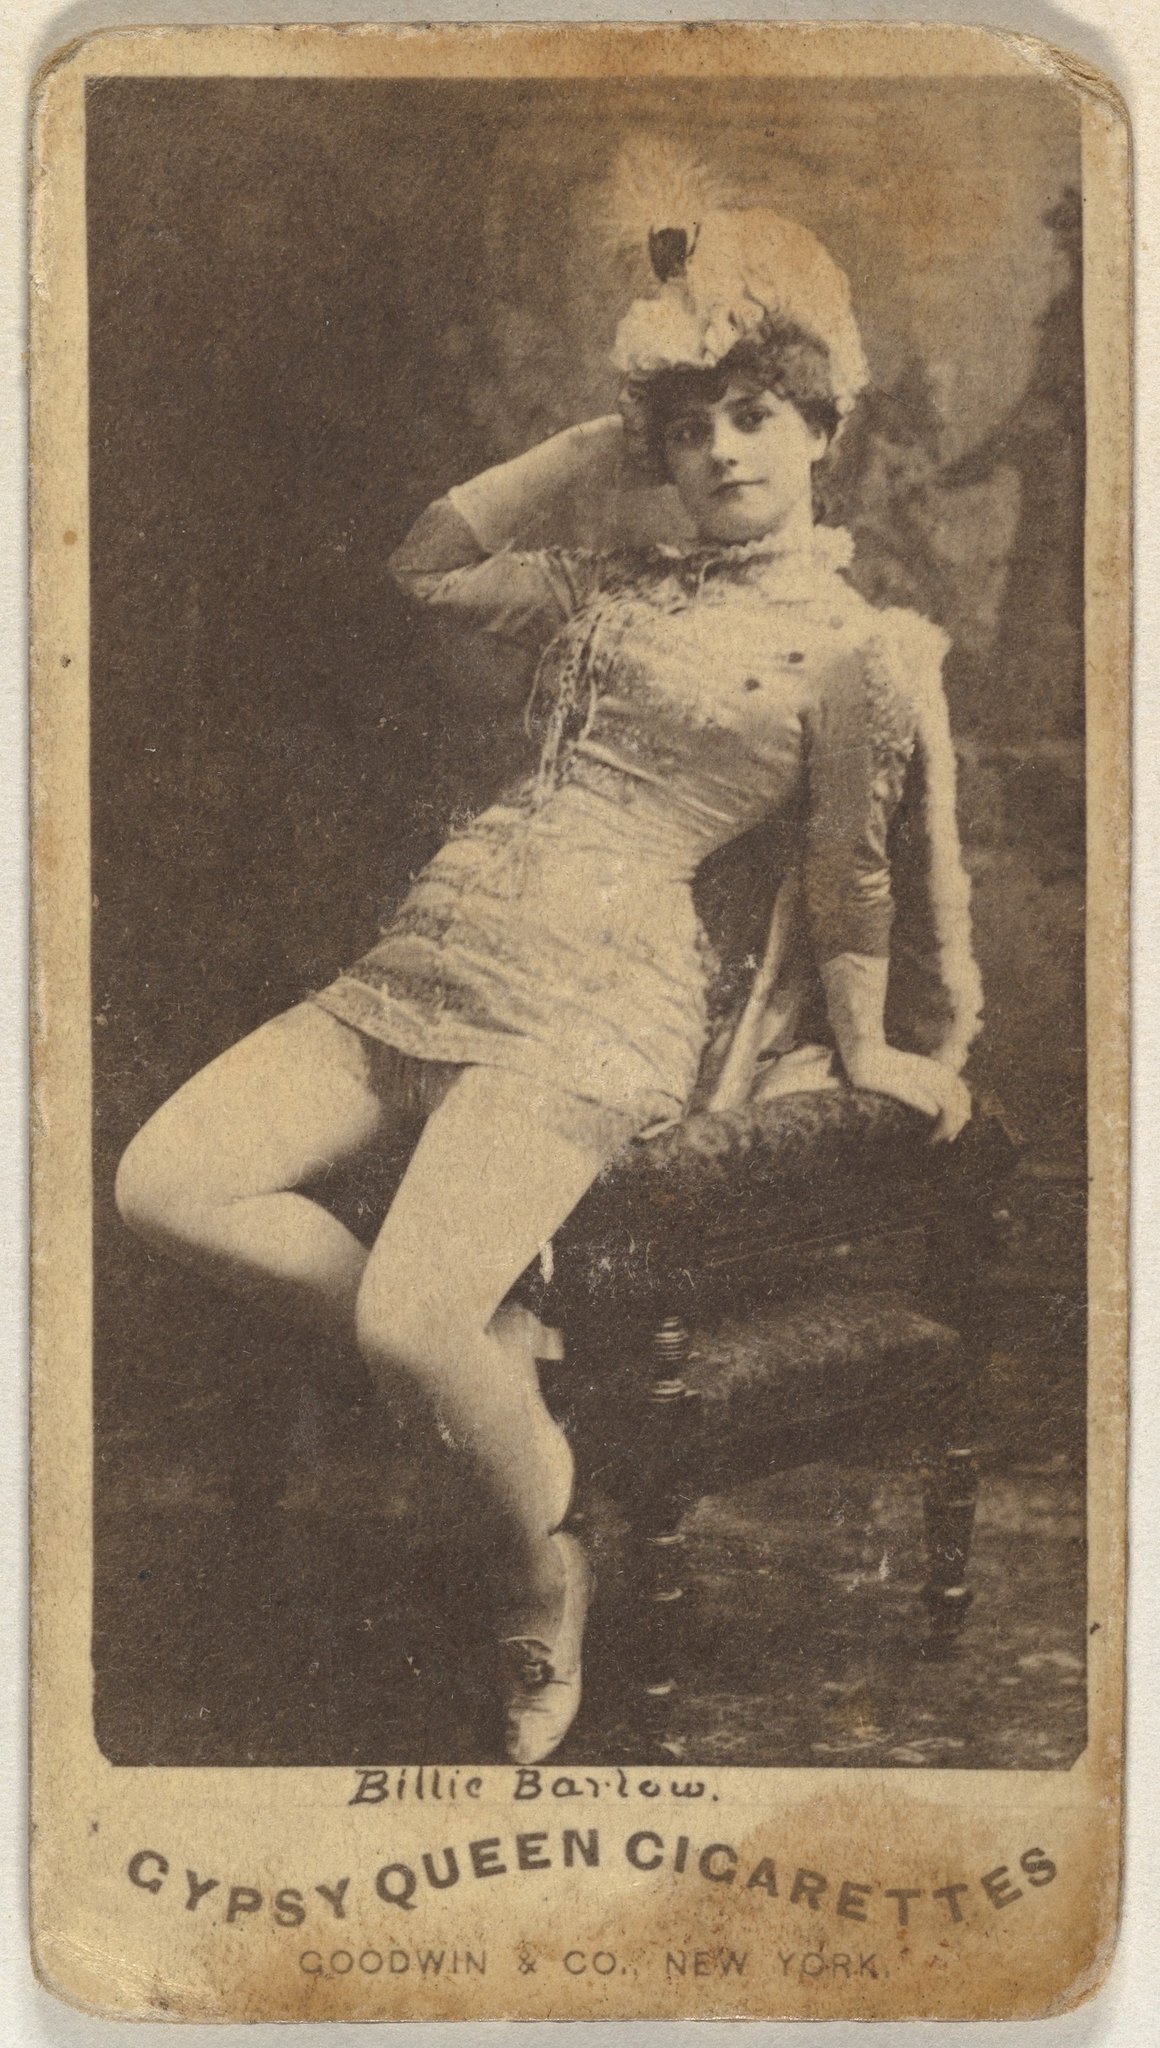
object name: photograph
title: Billie Barlow, from the Actors and Actresses series (N171) for Gypsy Queen Cigarettes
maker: goodwin & company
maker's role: publisher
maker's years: 1850-1950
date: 1886-1890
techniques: albumen silver print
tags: portraits,women,actresses